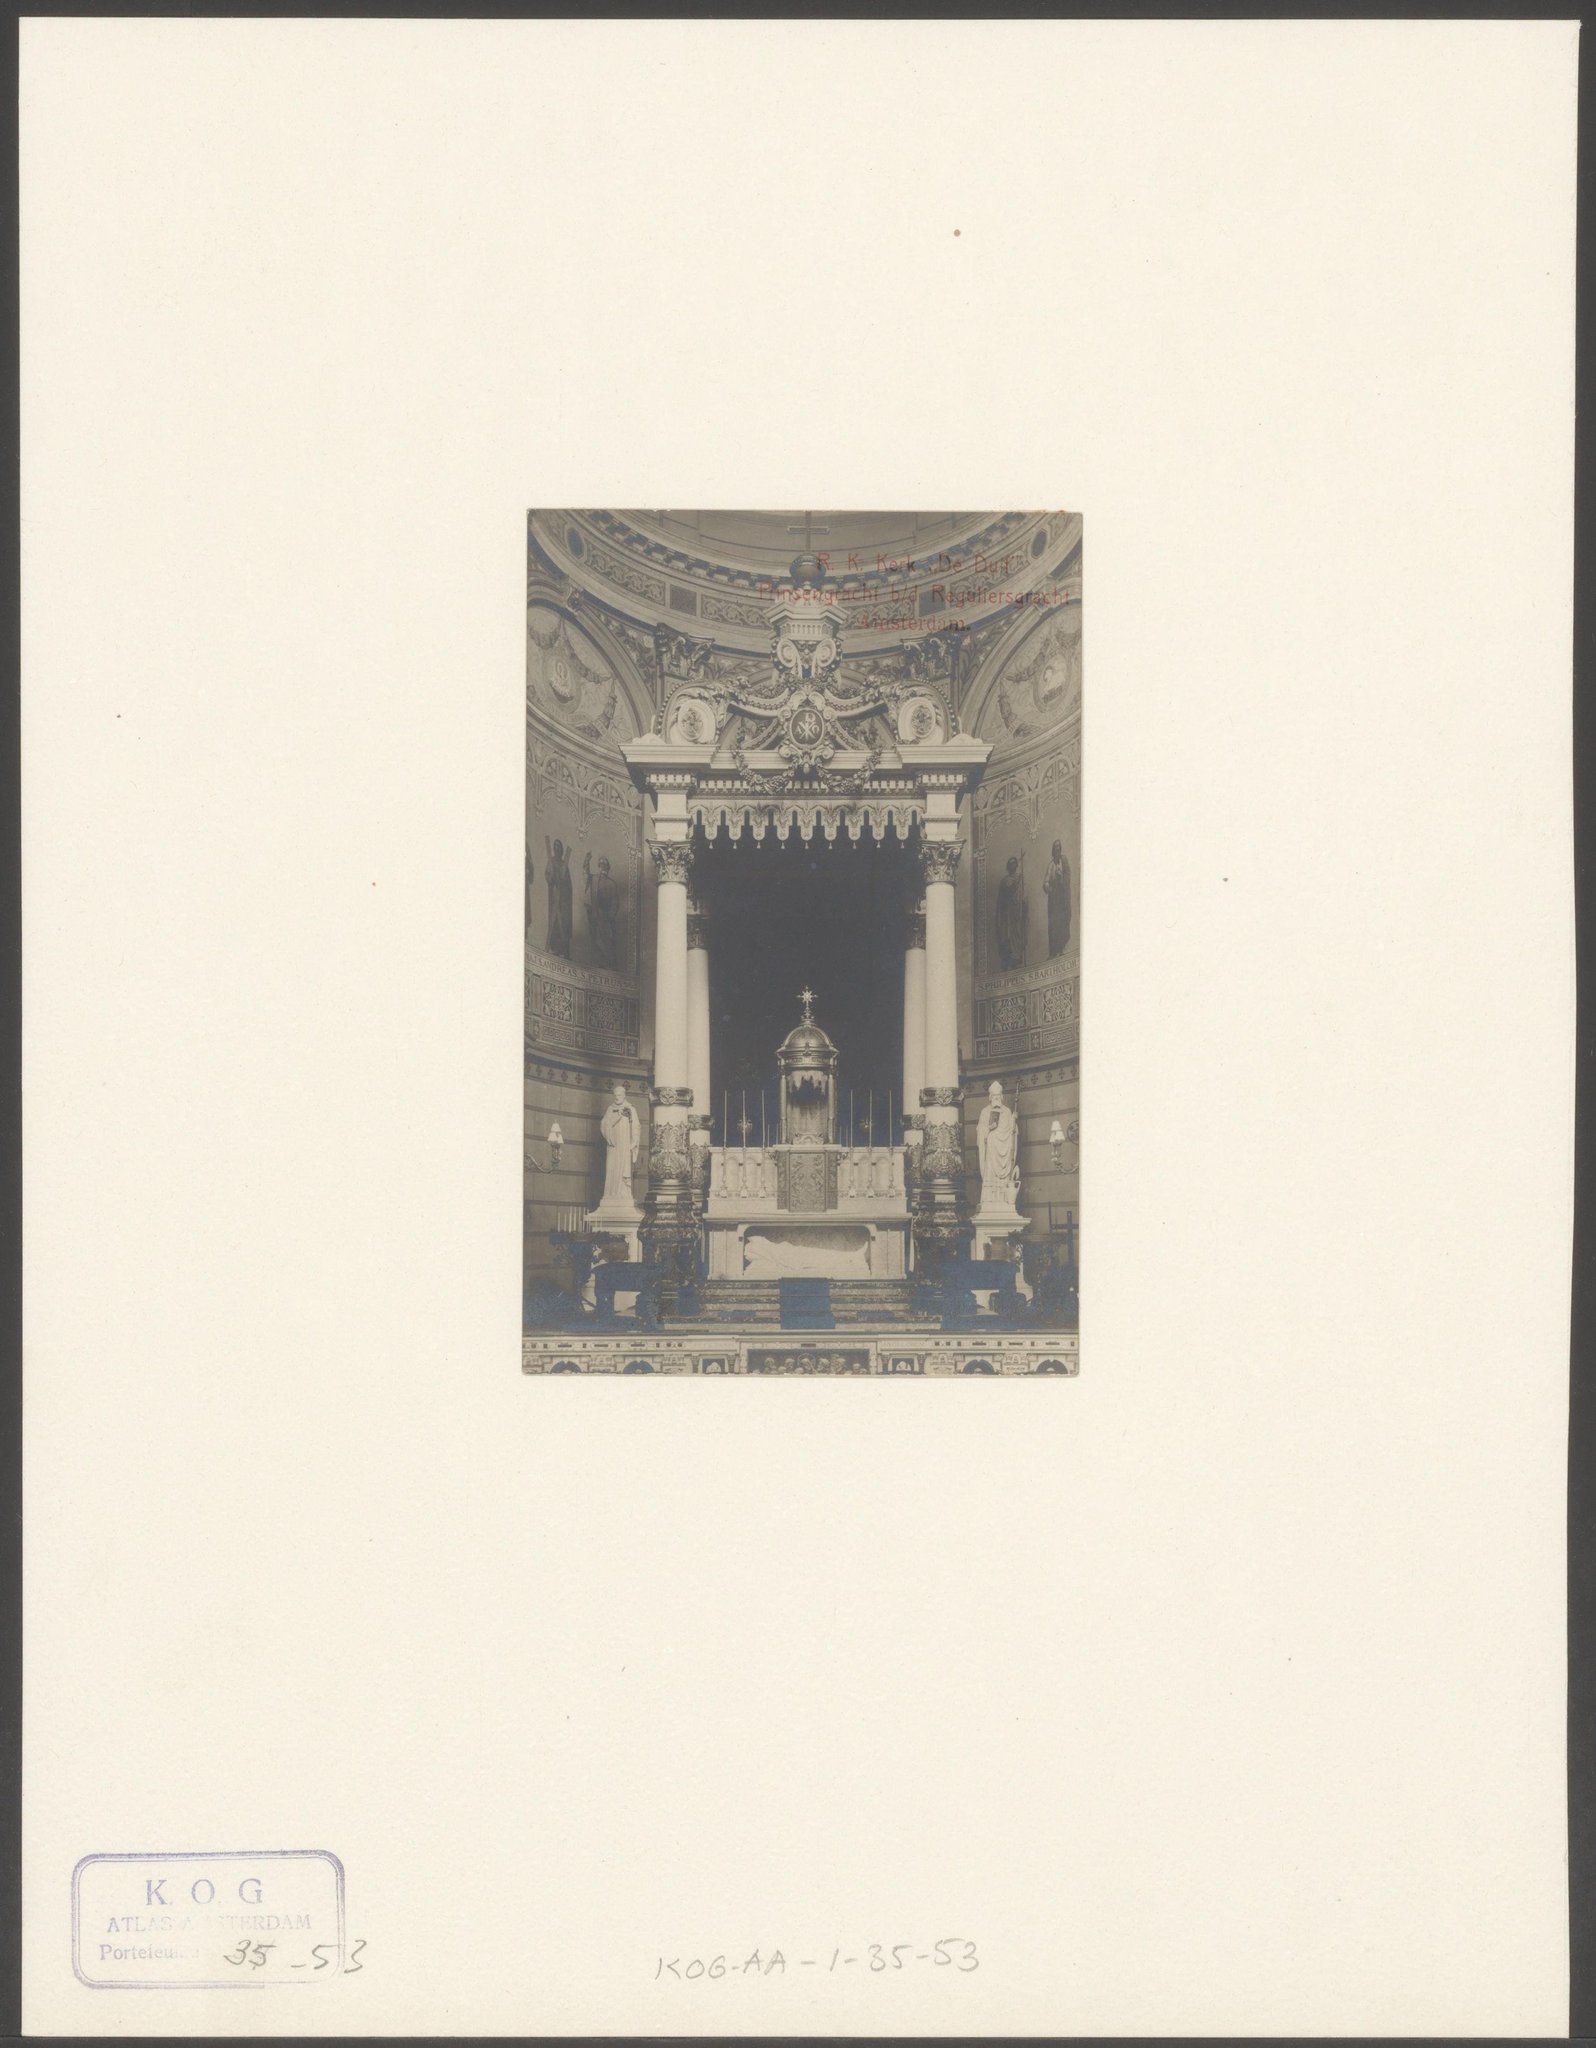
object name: ansichtkaart, prentbriefkaart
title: R.K. Kerk "De Duif" / Prinsengracht b/d Reguliersgracht / Amsterdam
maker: Anonymous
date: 1900-1930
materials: paper, cardboard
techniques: gelatin silver print, letterpress printing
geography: amsterdam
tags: parts of church interior: aisle, fixed altar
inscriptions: collector's mark: ‘17’ Lugt 1641b, collector's mark: ‘35-53’ Lugt 1641b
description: Onderwerpsrubriek binnen de Atlas Amsterdam: R.K. Gemeenten: Sint Nicolaaskerk t/m Willibrordus (Rustenburgerstraat).